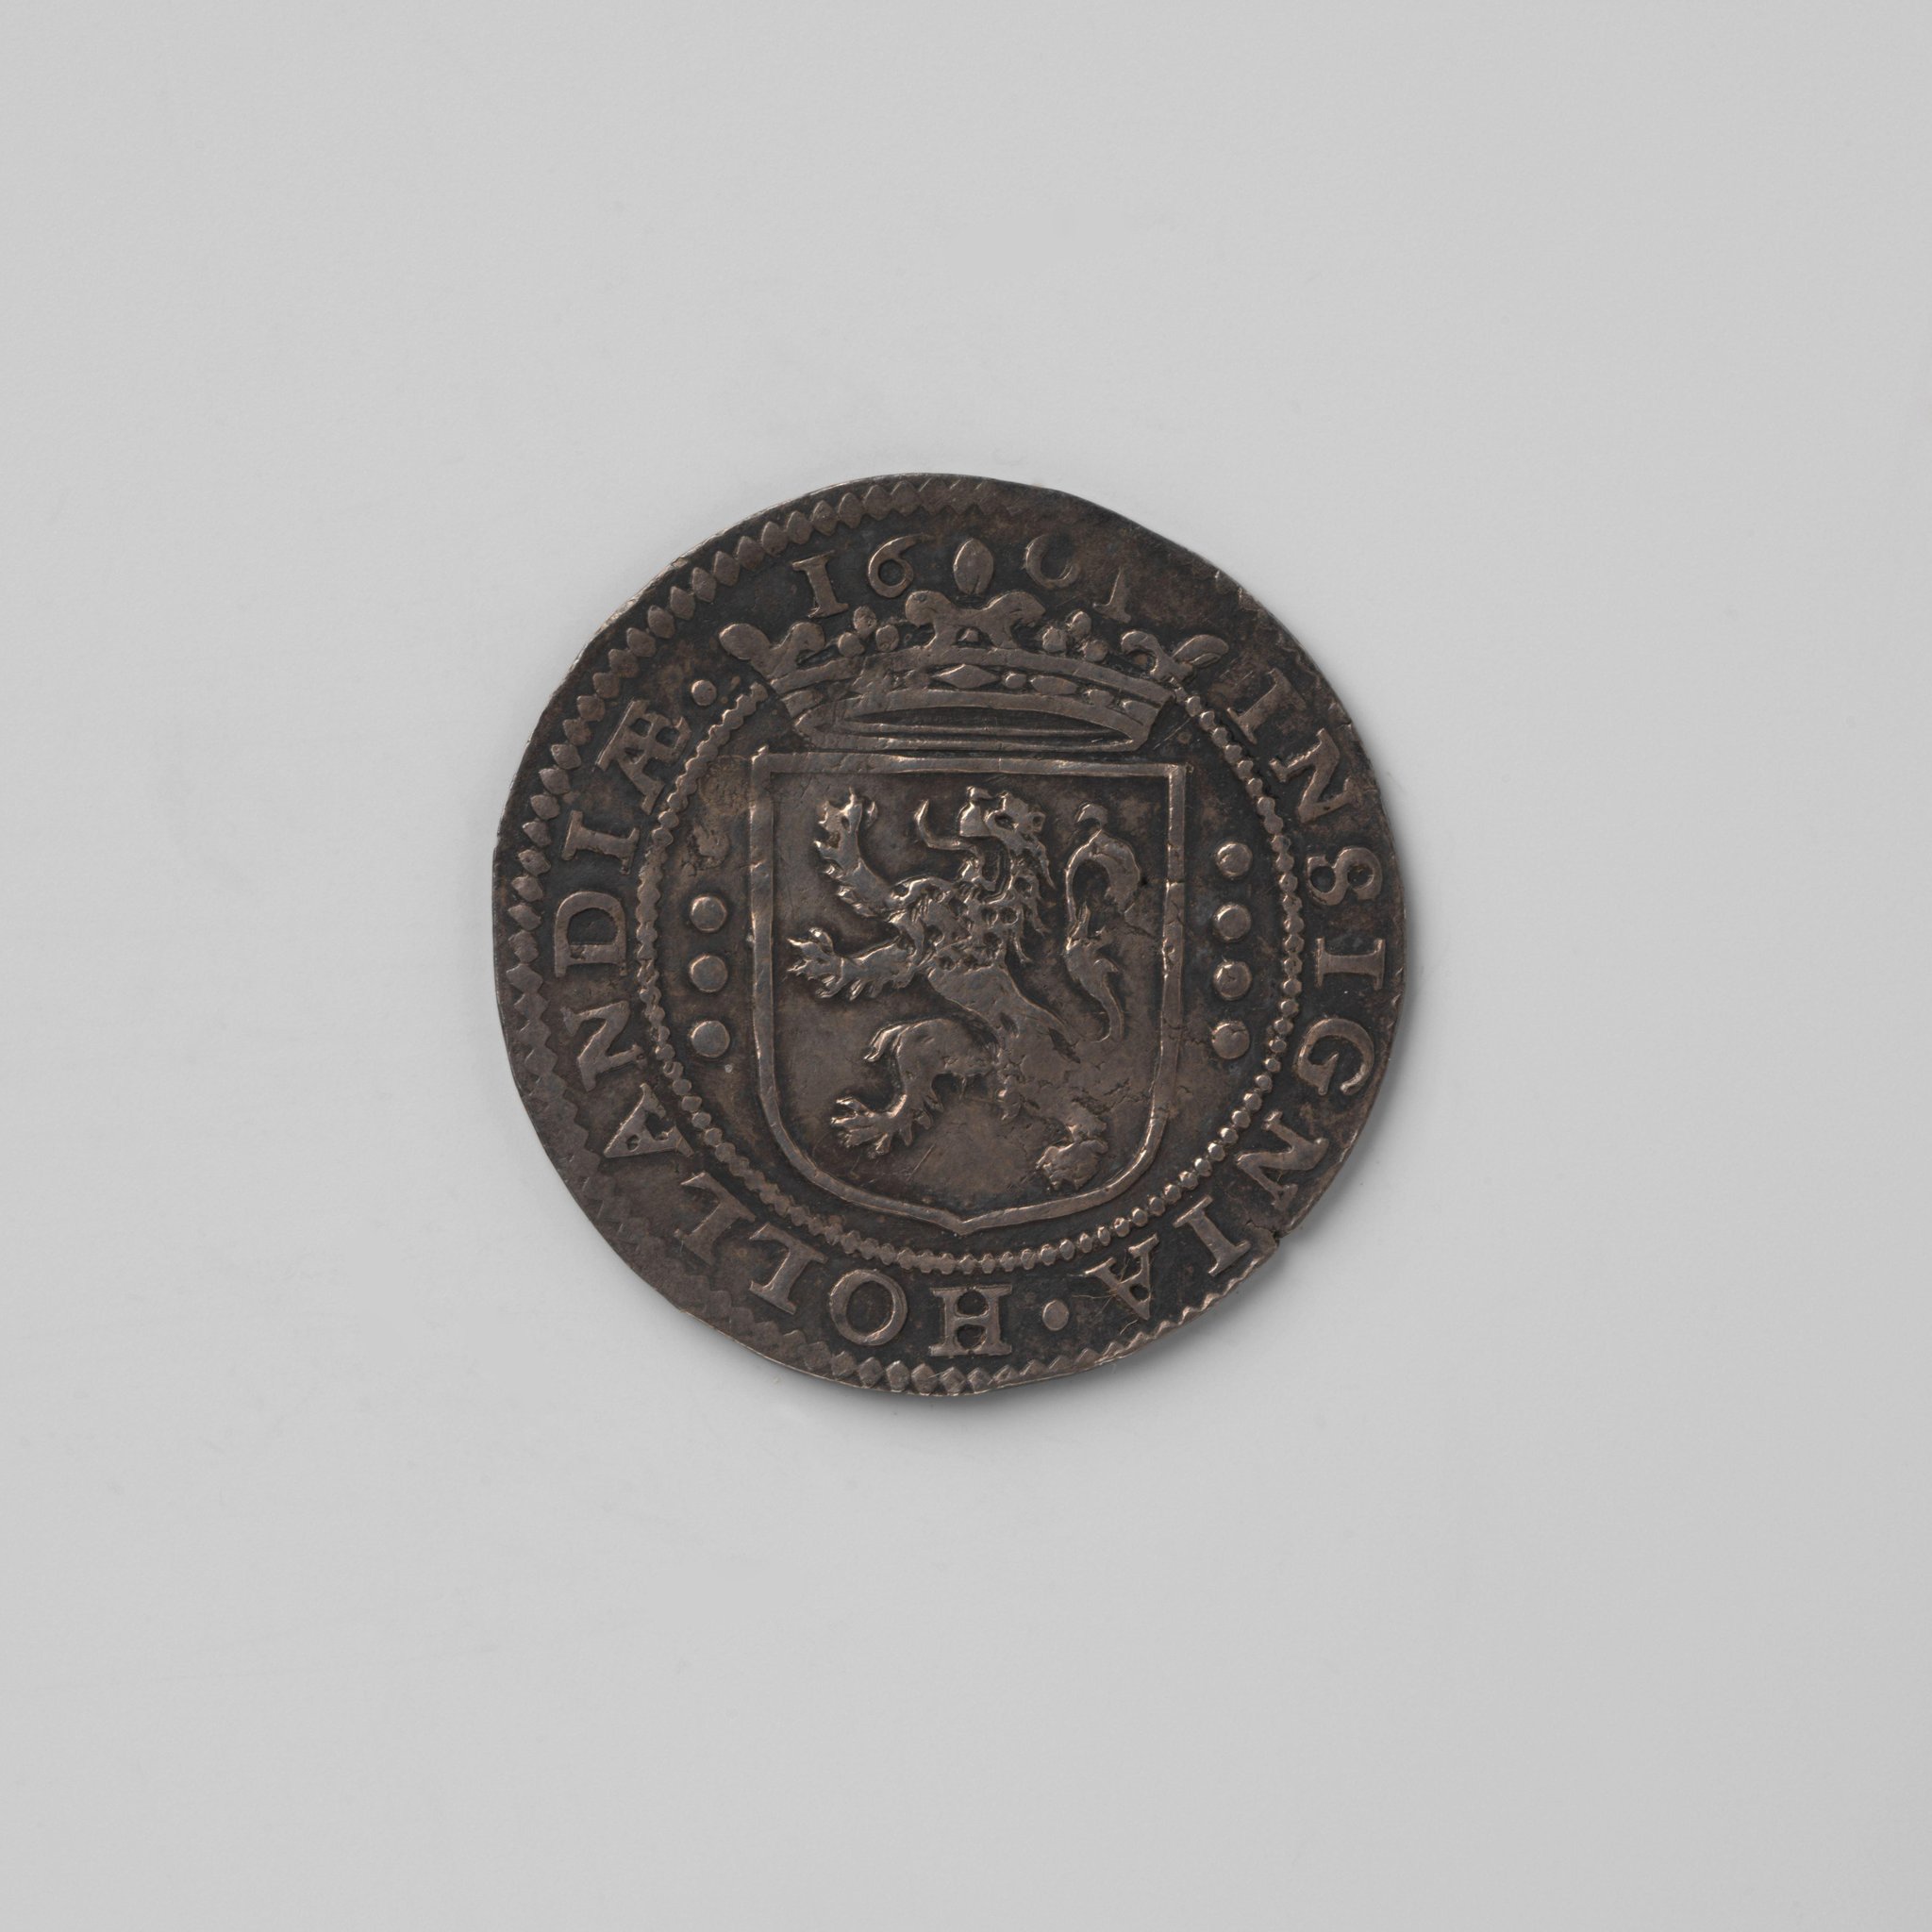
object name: real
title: Verenigde Amsterdamse Compagnie, reaal, 1601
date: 1601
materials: silver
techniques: striking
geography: dordrecht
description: Zilveren munt. Voorzijde: tussen waarde-aanduiding gekroond wapenschild van Holland, waarboven jaartal. Keerzijde: door twee leeuwen gehouden wapenschild van Amsterdam.